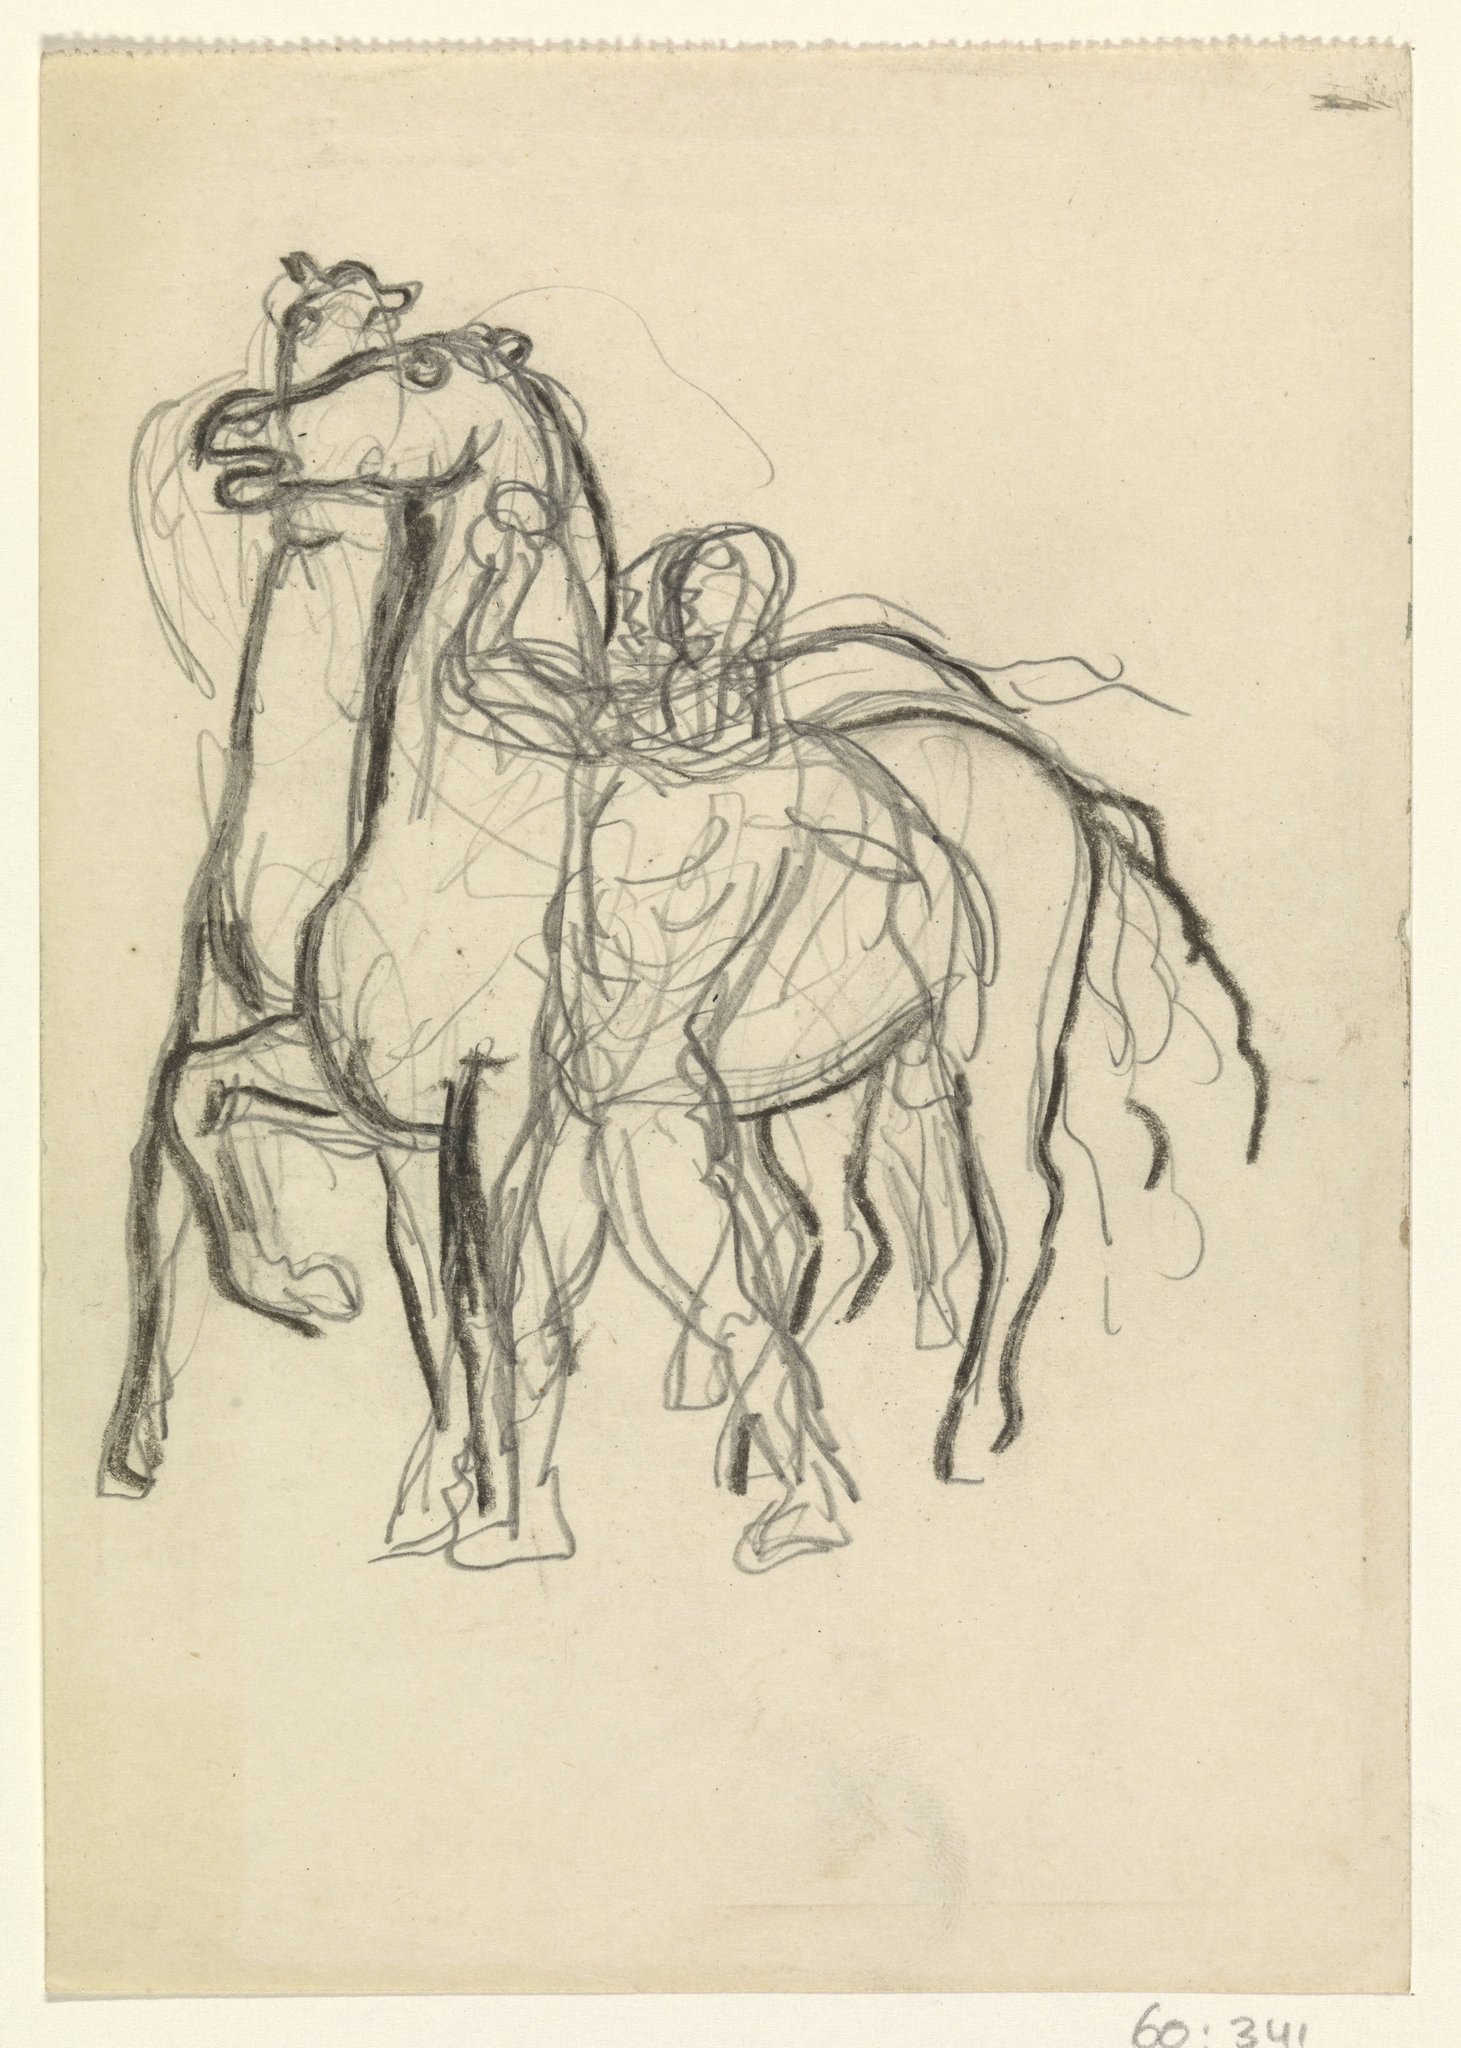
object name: drawing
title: Man houdt twee paarden in toom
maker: leo gestel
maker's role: draughtsman, print maker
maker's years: 1881-1941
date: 1891-1941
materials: chalk, paper, pencil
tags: horse, male sex; man